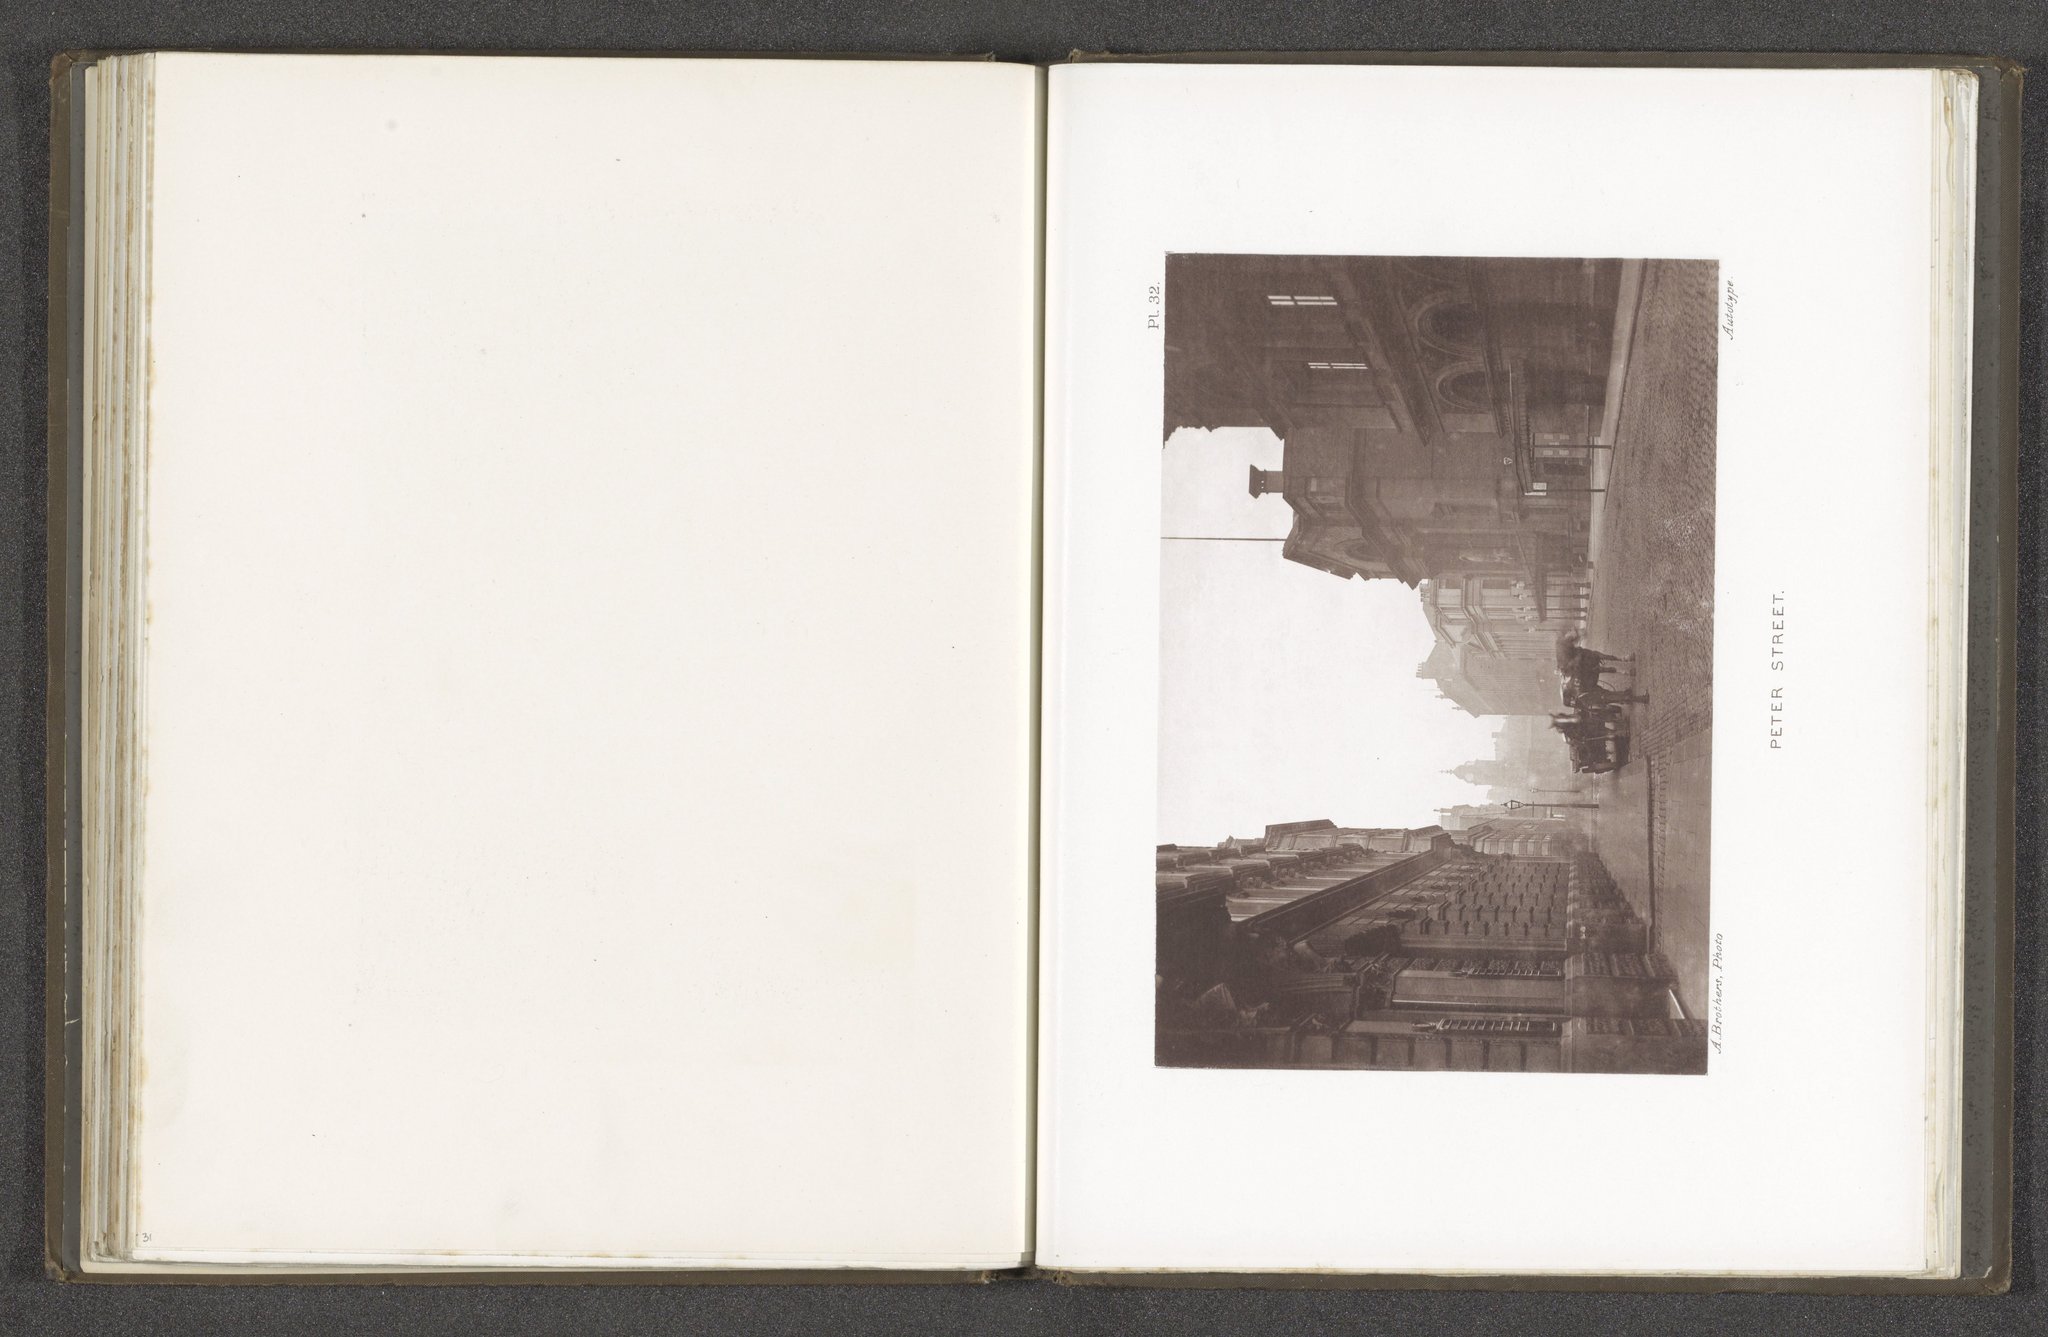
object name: page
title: Gezicht op Peter Street in Manchester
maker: Anonymous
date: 1868-1878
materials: paper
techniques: photograph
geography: manchester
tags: four-wheeled, animal-drawn vehicle, e.g.: cab, carriage, coach, street, manchester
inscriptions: number: ‘Pl. 32.’